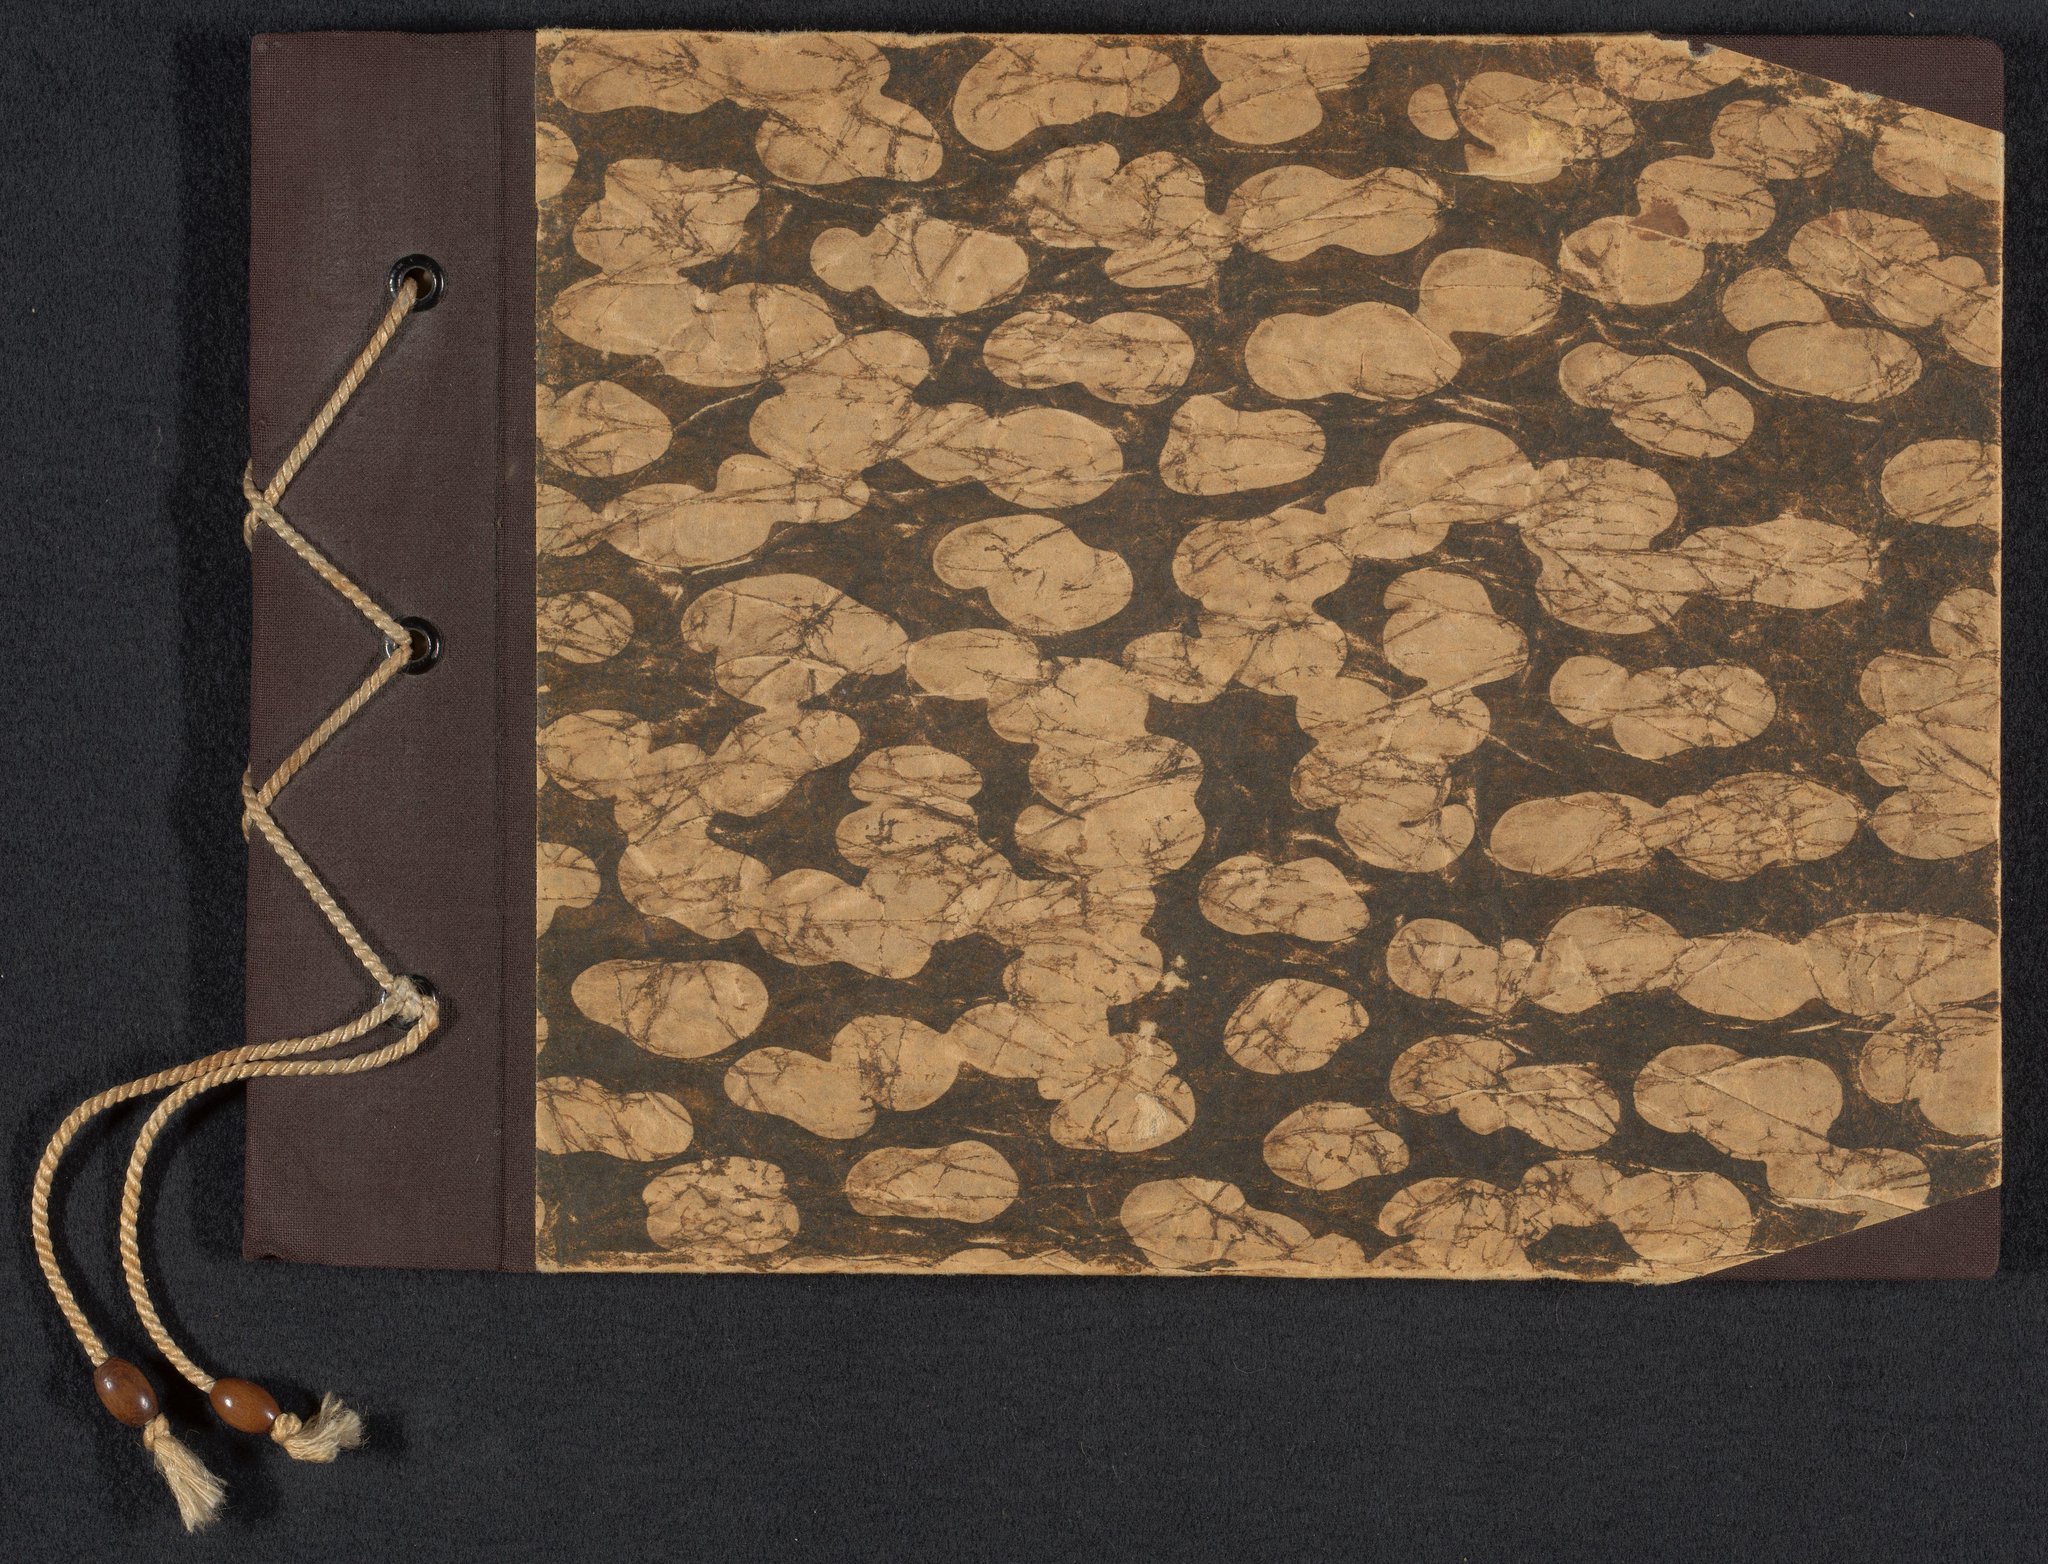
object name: photograph album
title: Fotoalbum met foto's van Else Wachenheimer-Moos en Eugen Wachenheimer op reis in Bulgarije, genomen tussen 1926 en 1927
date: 1926-1927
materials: cardboard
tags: eugen wachenheimer, else wachenheimer-moos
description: bijschriften geschreven in het handschrift van Else Wachenheimer-Moos. Dit object is onderdeel van de nalatenschap van Isabel Elon-Wachenheimer (1928-2010). Tot haar overlijden behoorde het samen met de andere objecten uit de nalatenschap tot haar privédomein van Isabel Wachenheimer. In die particuliere context zijn deze objecten tezamen en individueel aandenkens - aan de jeugd, ouders en familie van Isabel Wachenheimer vóór en tijdens de Shoah en aan haar leven na de Tweede Wereldoorlog. Isabel Wachenheimer, die van juni 1943 tot mei 1945 gevangen zat in Kamp Westerbork, Theresienstadt, Auschwitz, Lenzing a/d Oberdonau (een buitenkamp van Mauthausen), overleefde de Shoah. Haar ouders – Eugène Wachenheimer en Else Wachenheimer-Moos - werden op 14 oktober 1944 in Auschwitz-Birkenau vermoord.